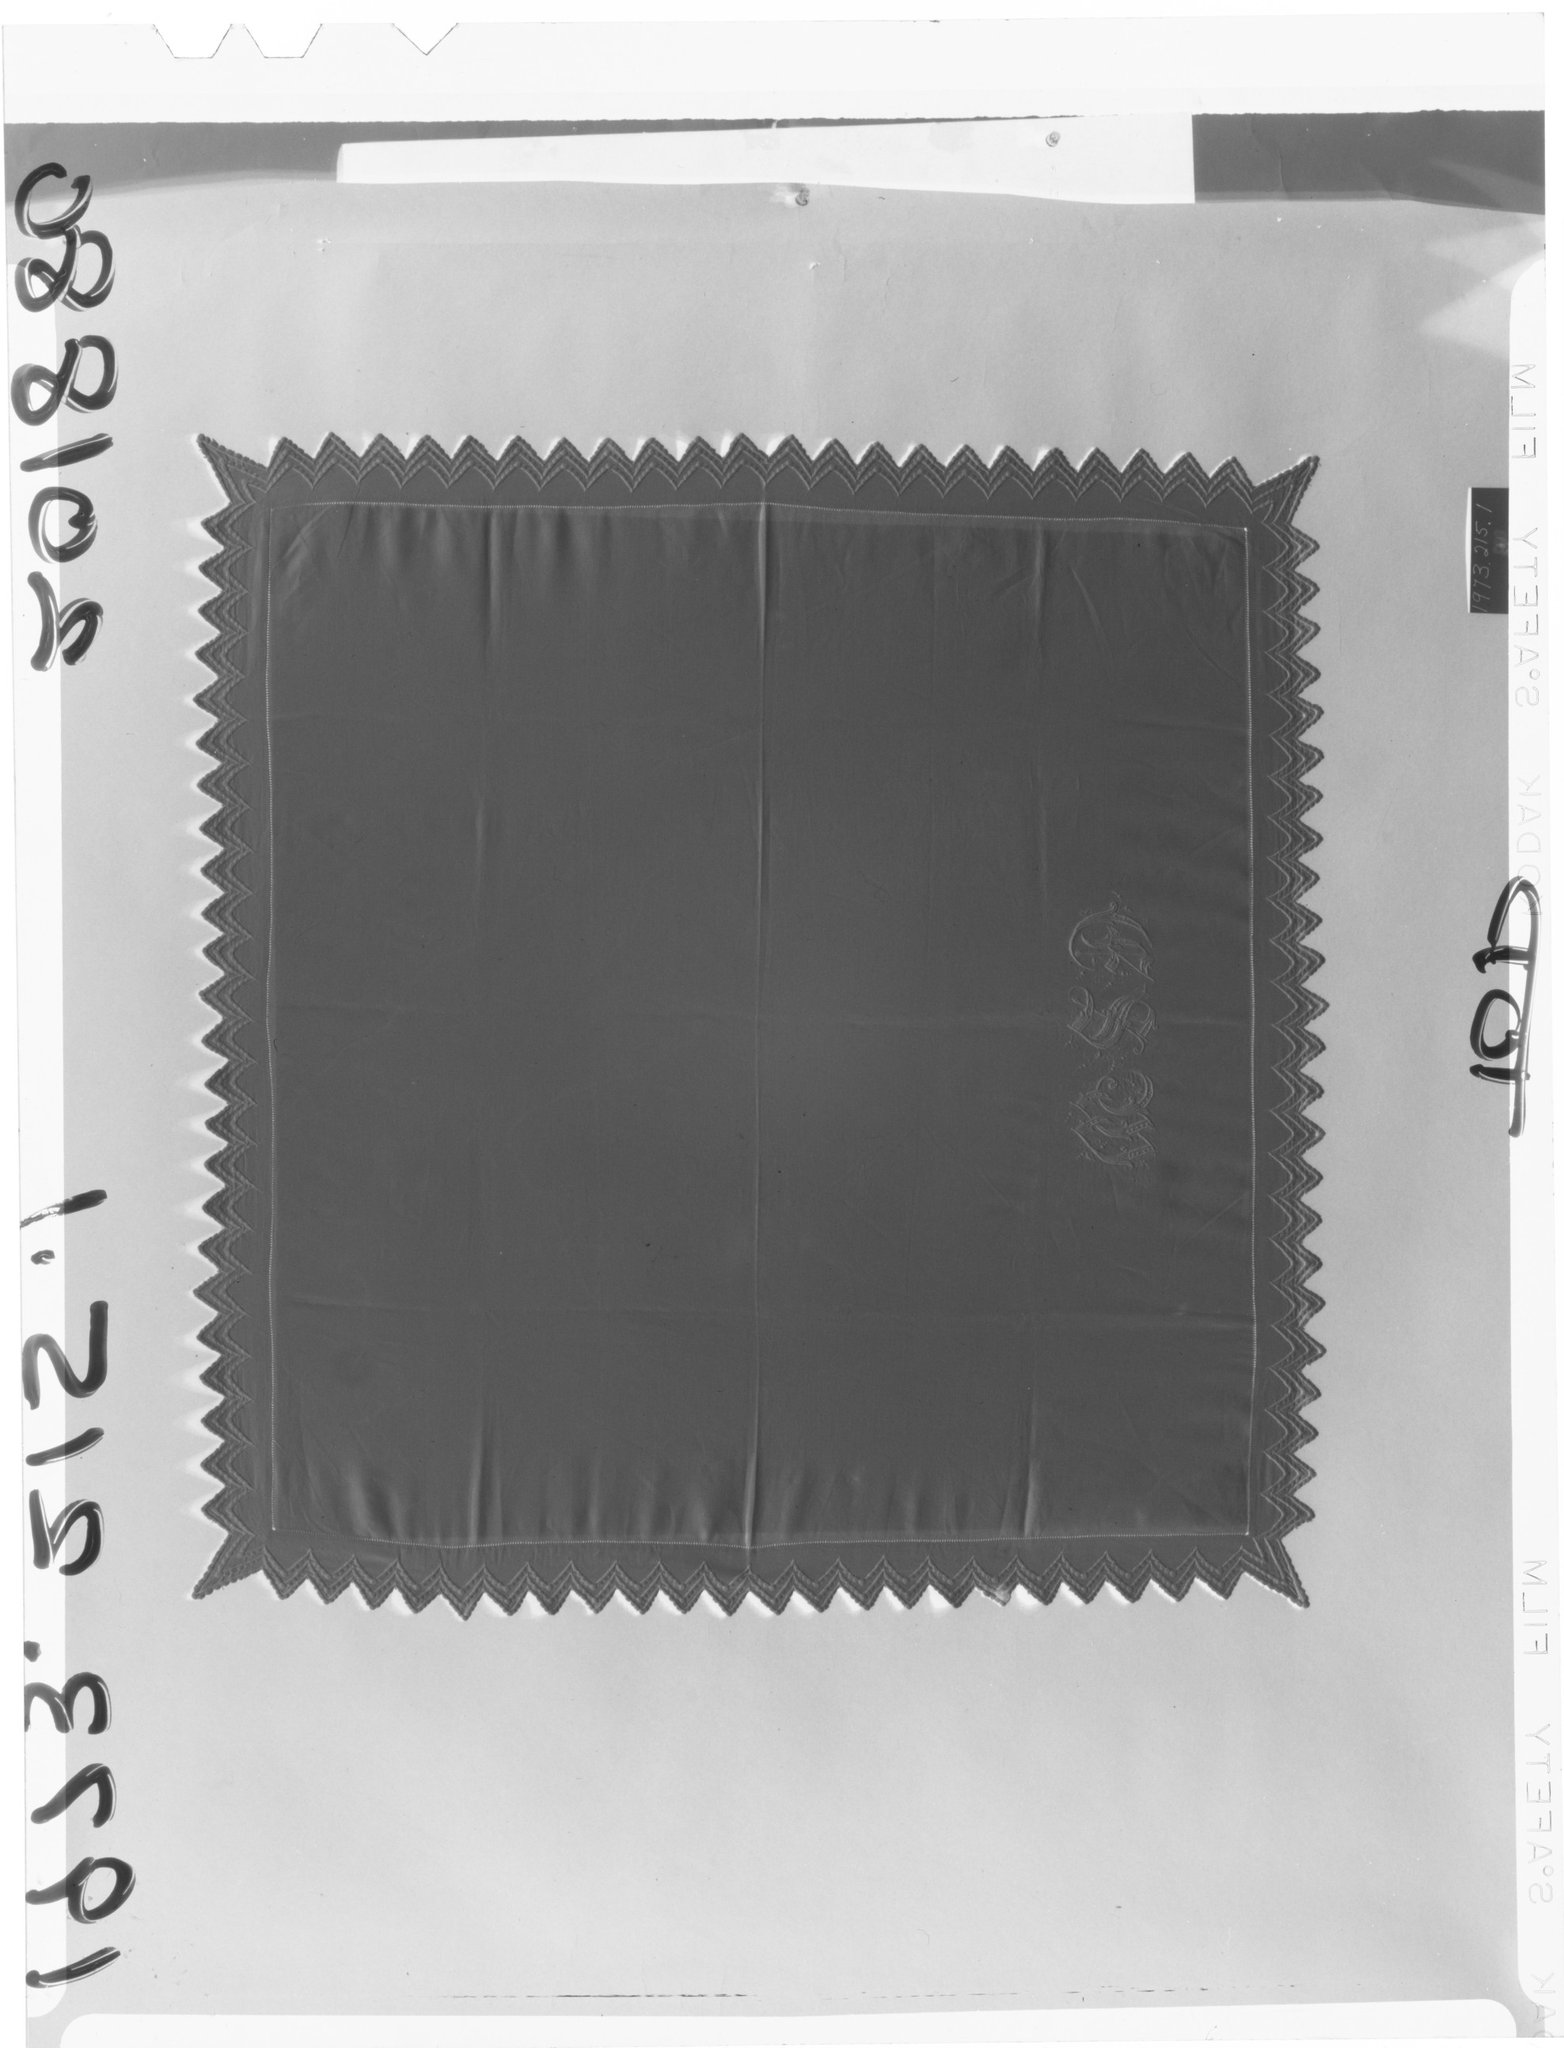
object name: pillow sham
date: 1890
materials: linen